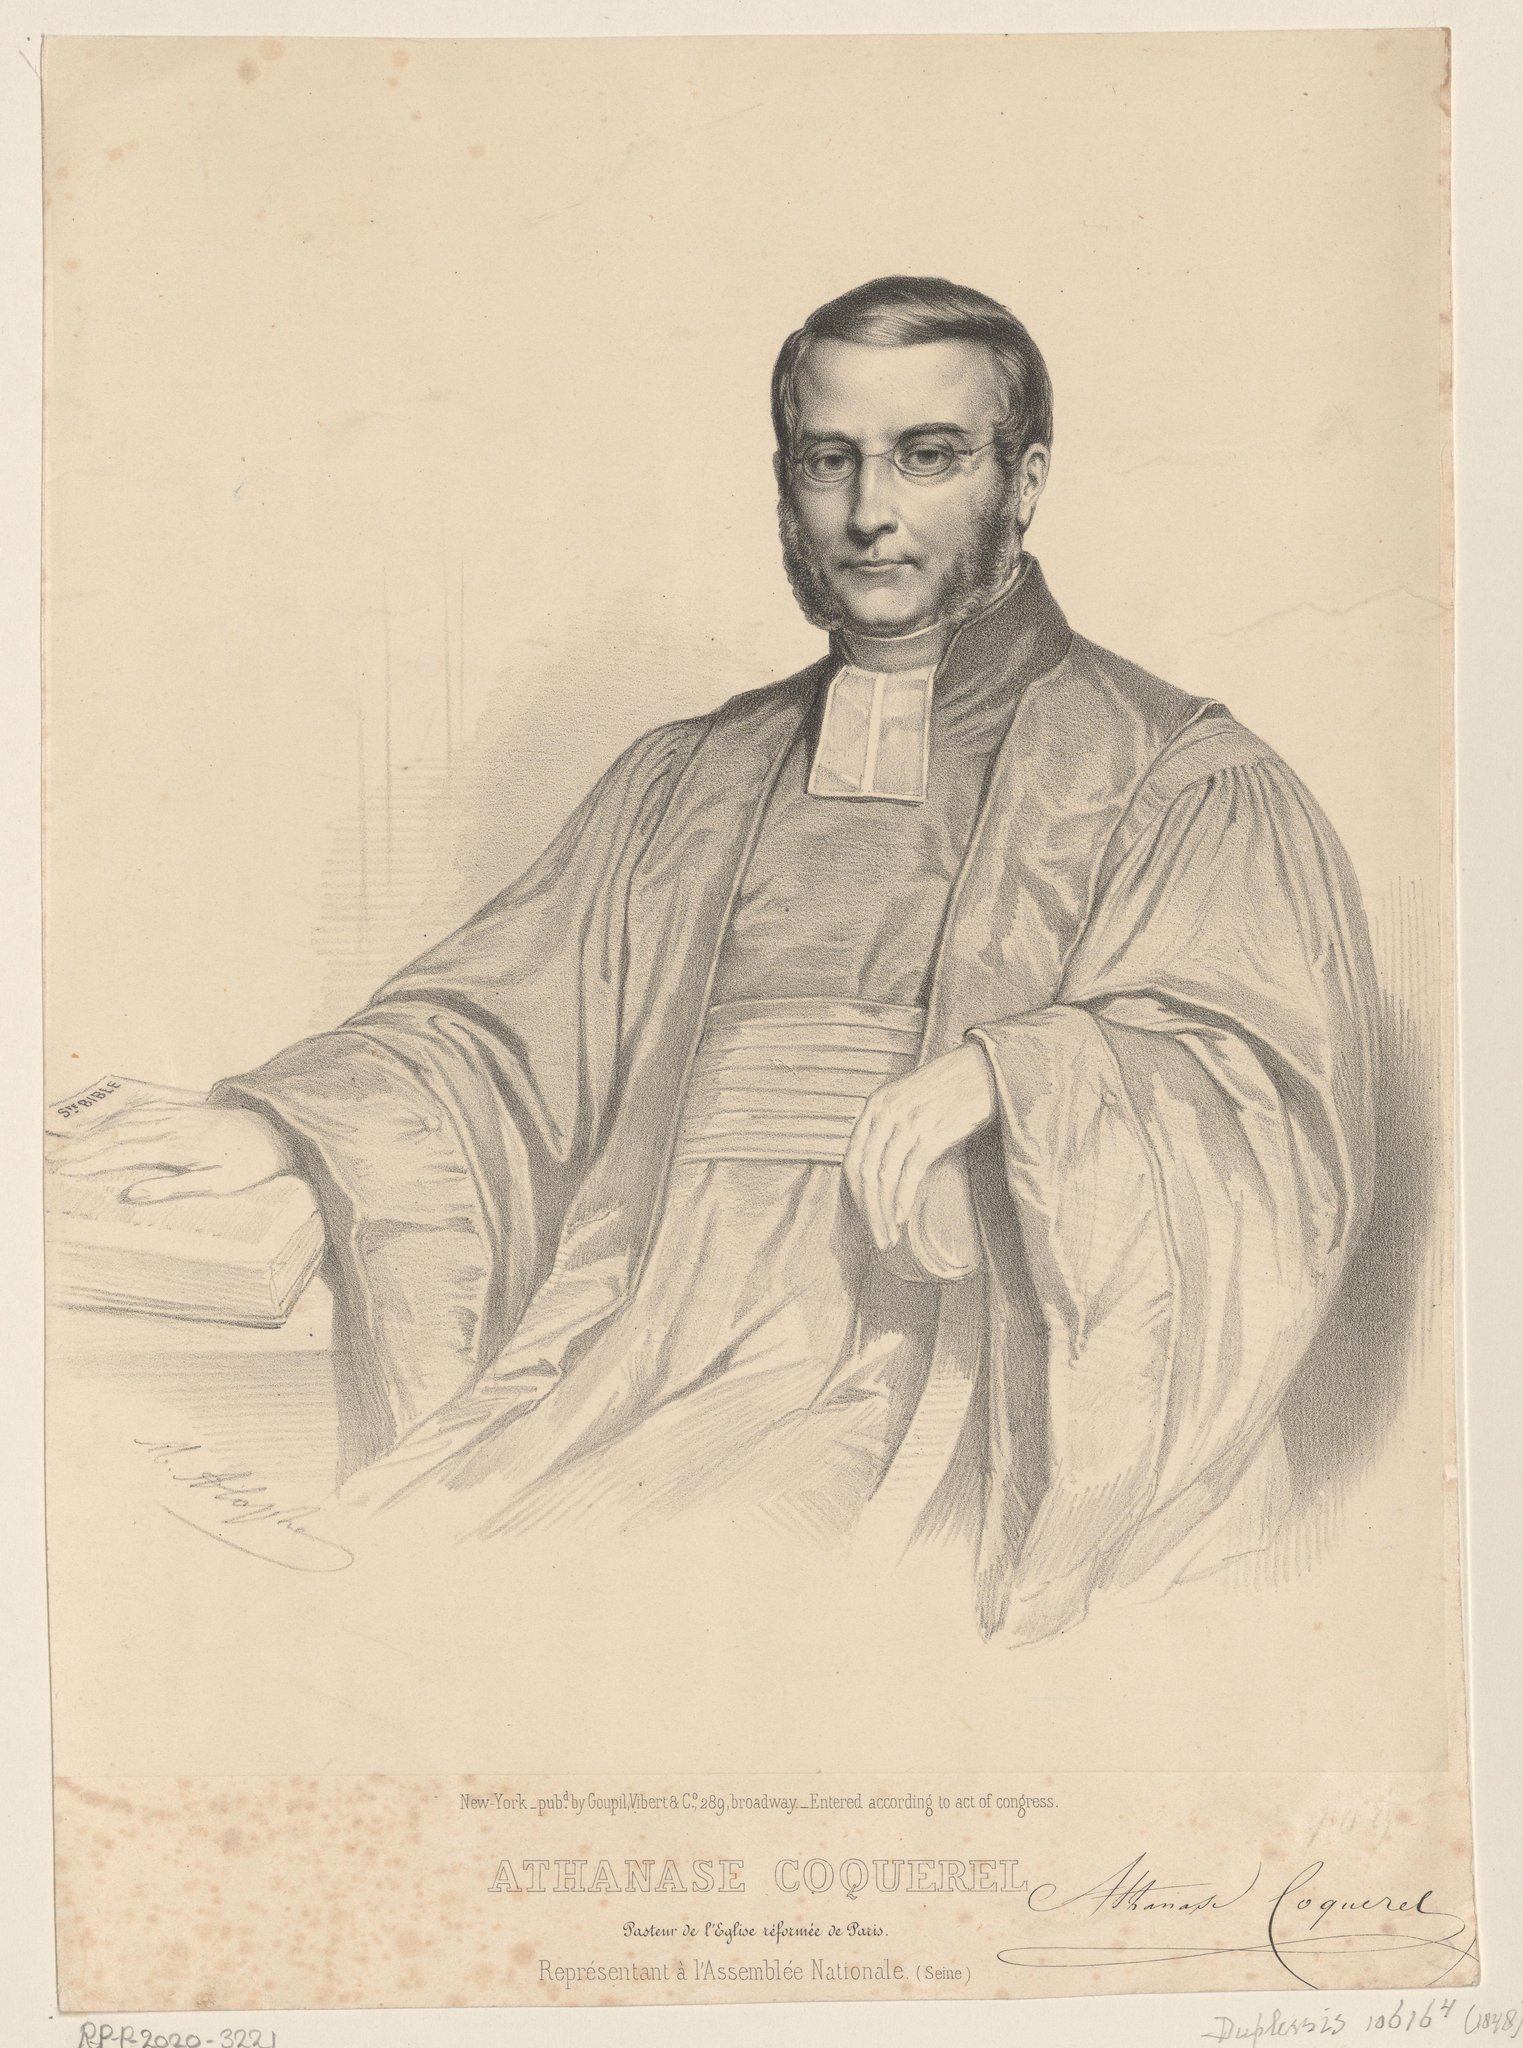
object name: print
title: Portret van Athanase Laurent Charles Coquerel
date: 1848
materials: paper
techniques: lithograph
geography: new york city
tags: historical persons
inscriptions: collector's mark: Lugt 2228